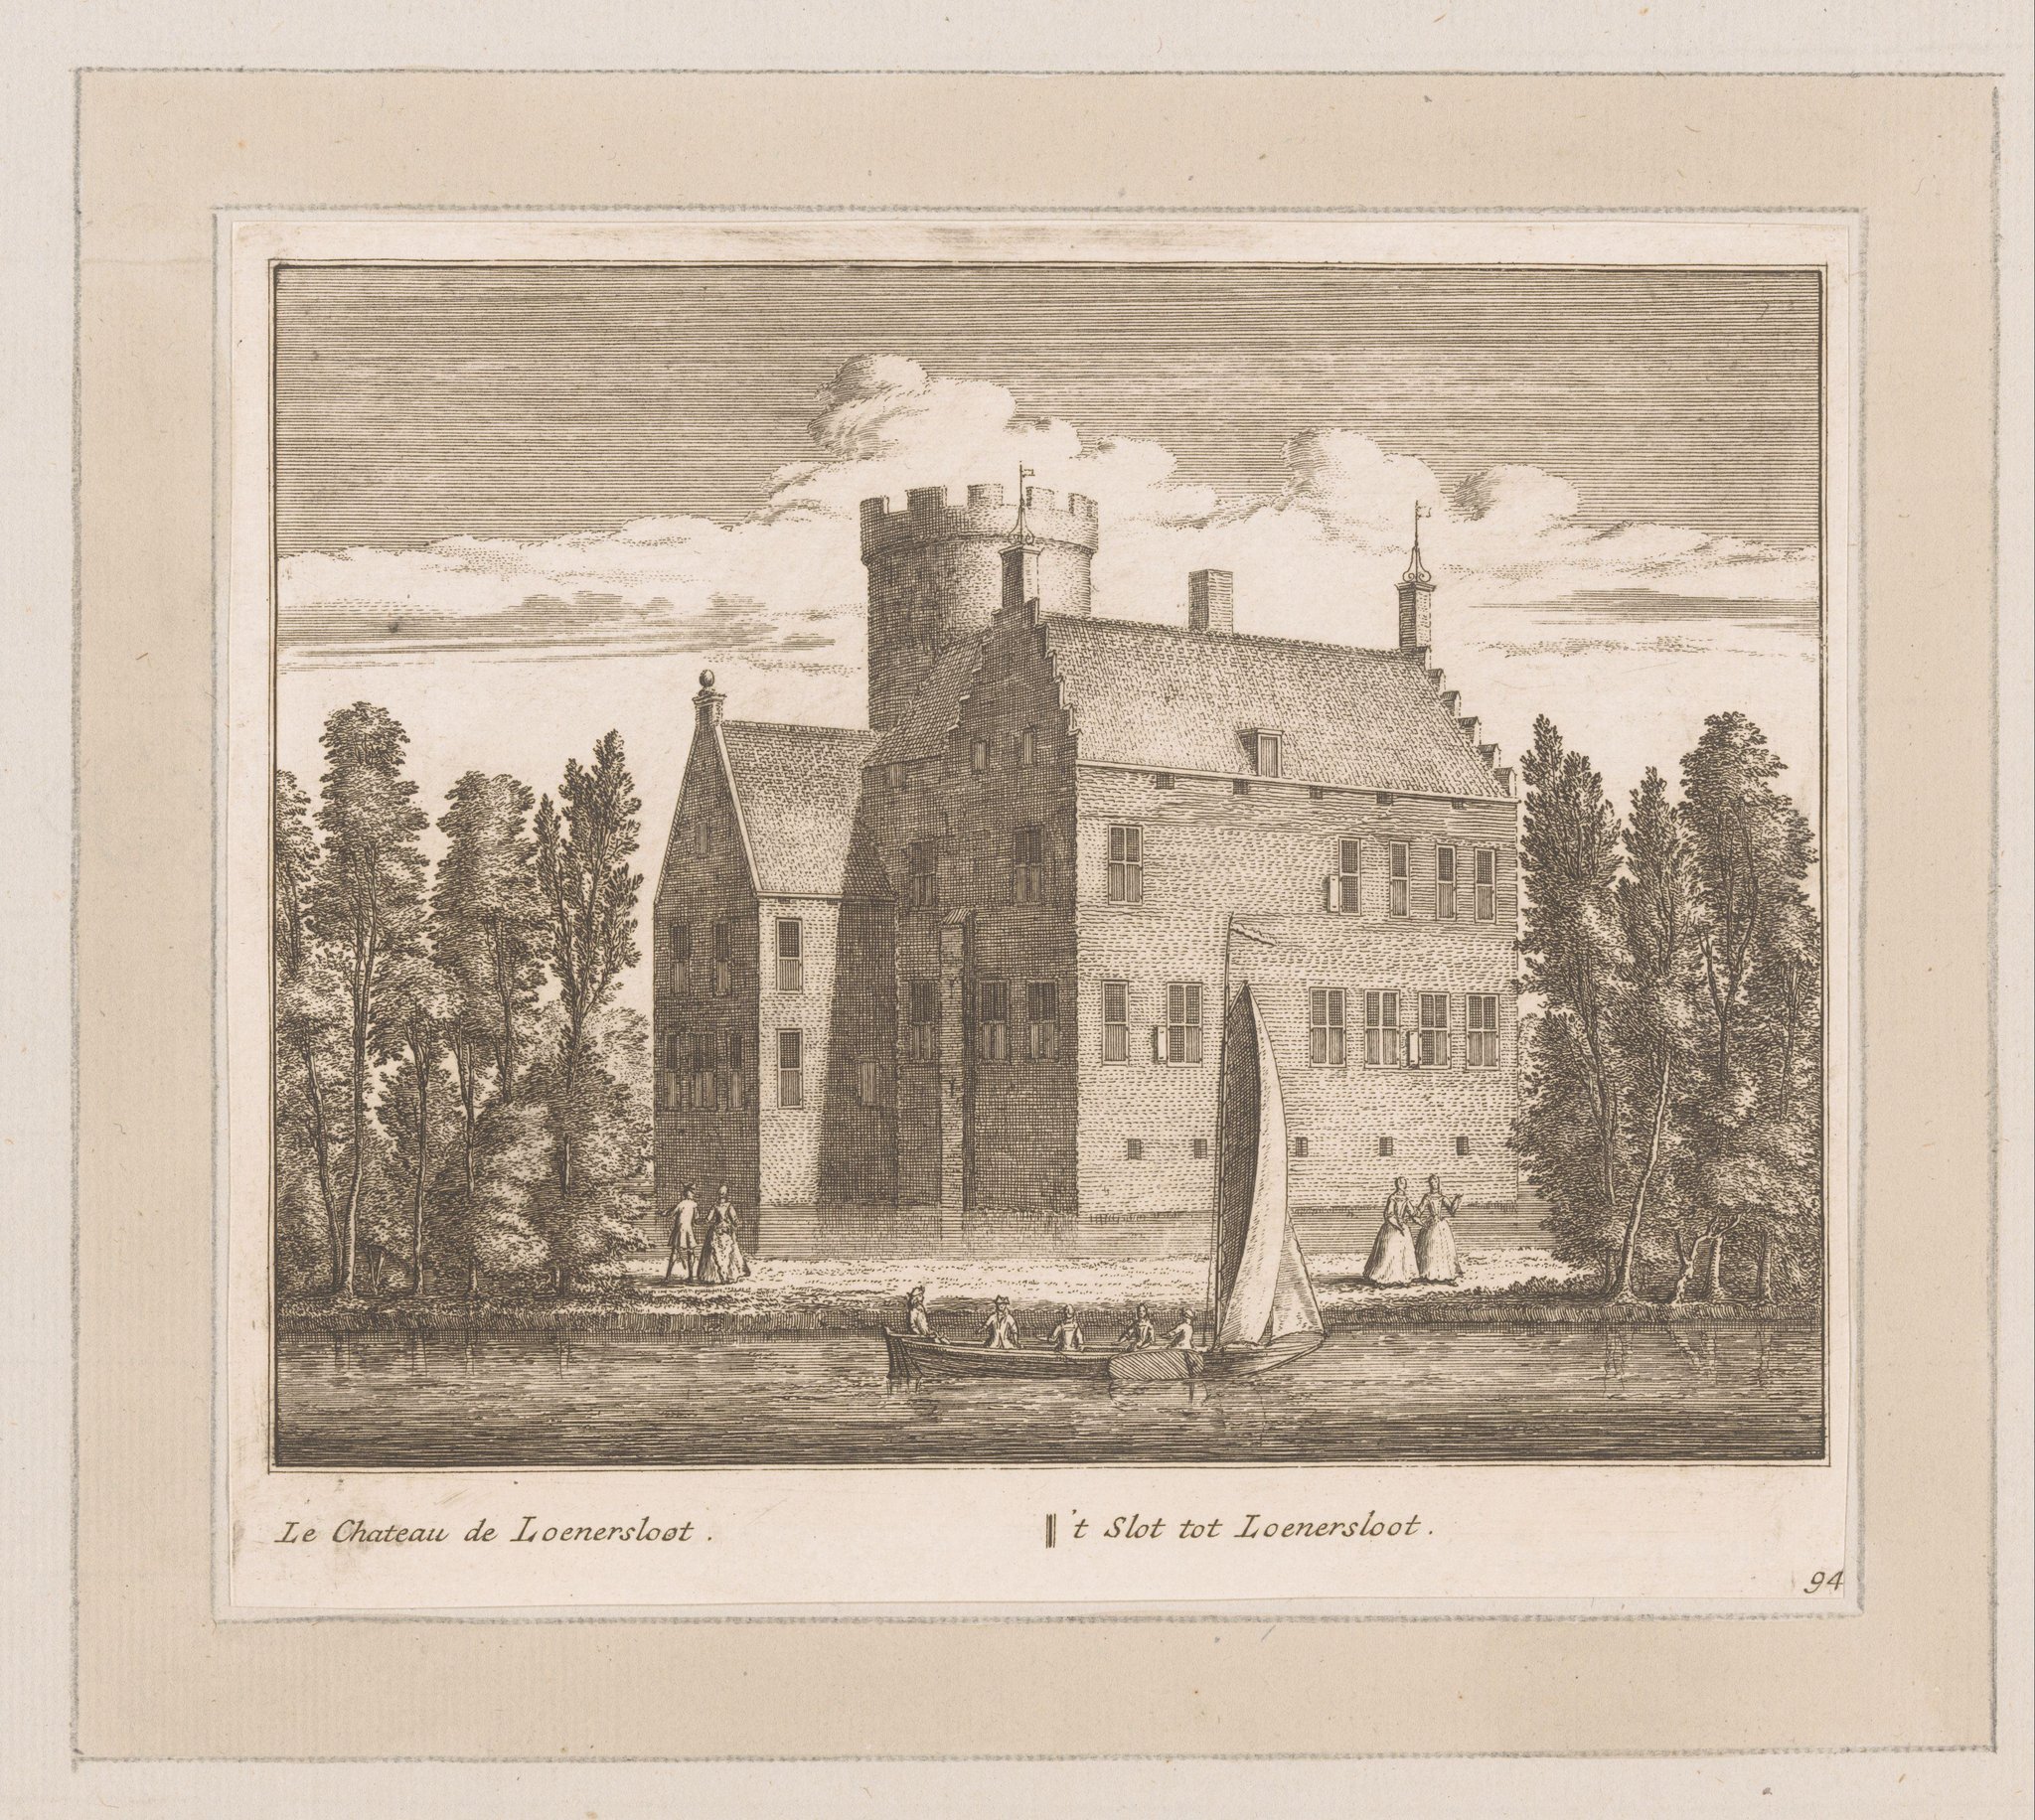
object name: print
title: Gezicht op kasteel Loenersloot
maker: abraham rademaker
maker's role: draughtsman, print maker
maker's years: 1676-1735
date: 1730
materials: paper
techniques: etching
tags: sailing-ship, sailing-boat, castle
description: Prent mogelijk uit: Rademaker, Abraham. Hollands Arcadia Of de vermaarde Rivier Den Amstel (...). Amsterdam: Leonard Schenk, 1730.